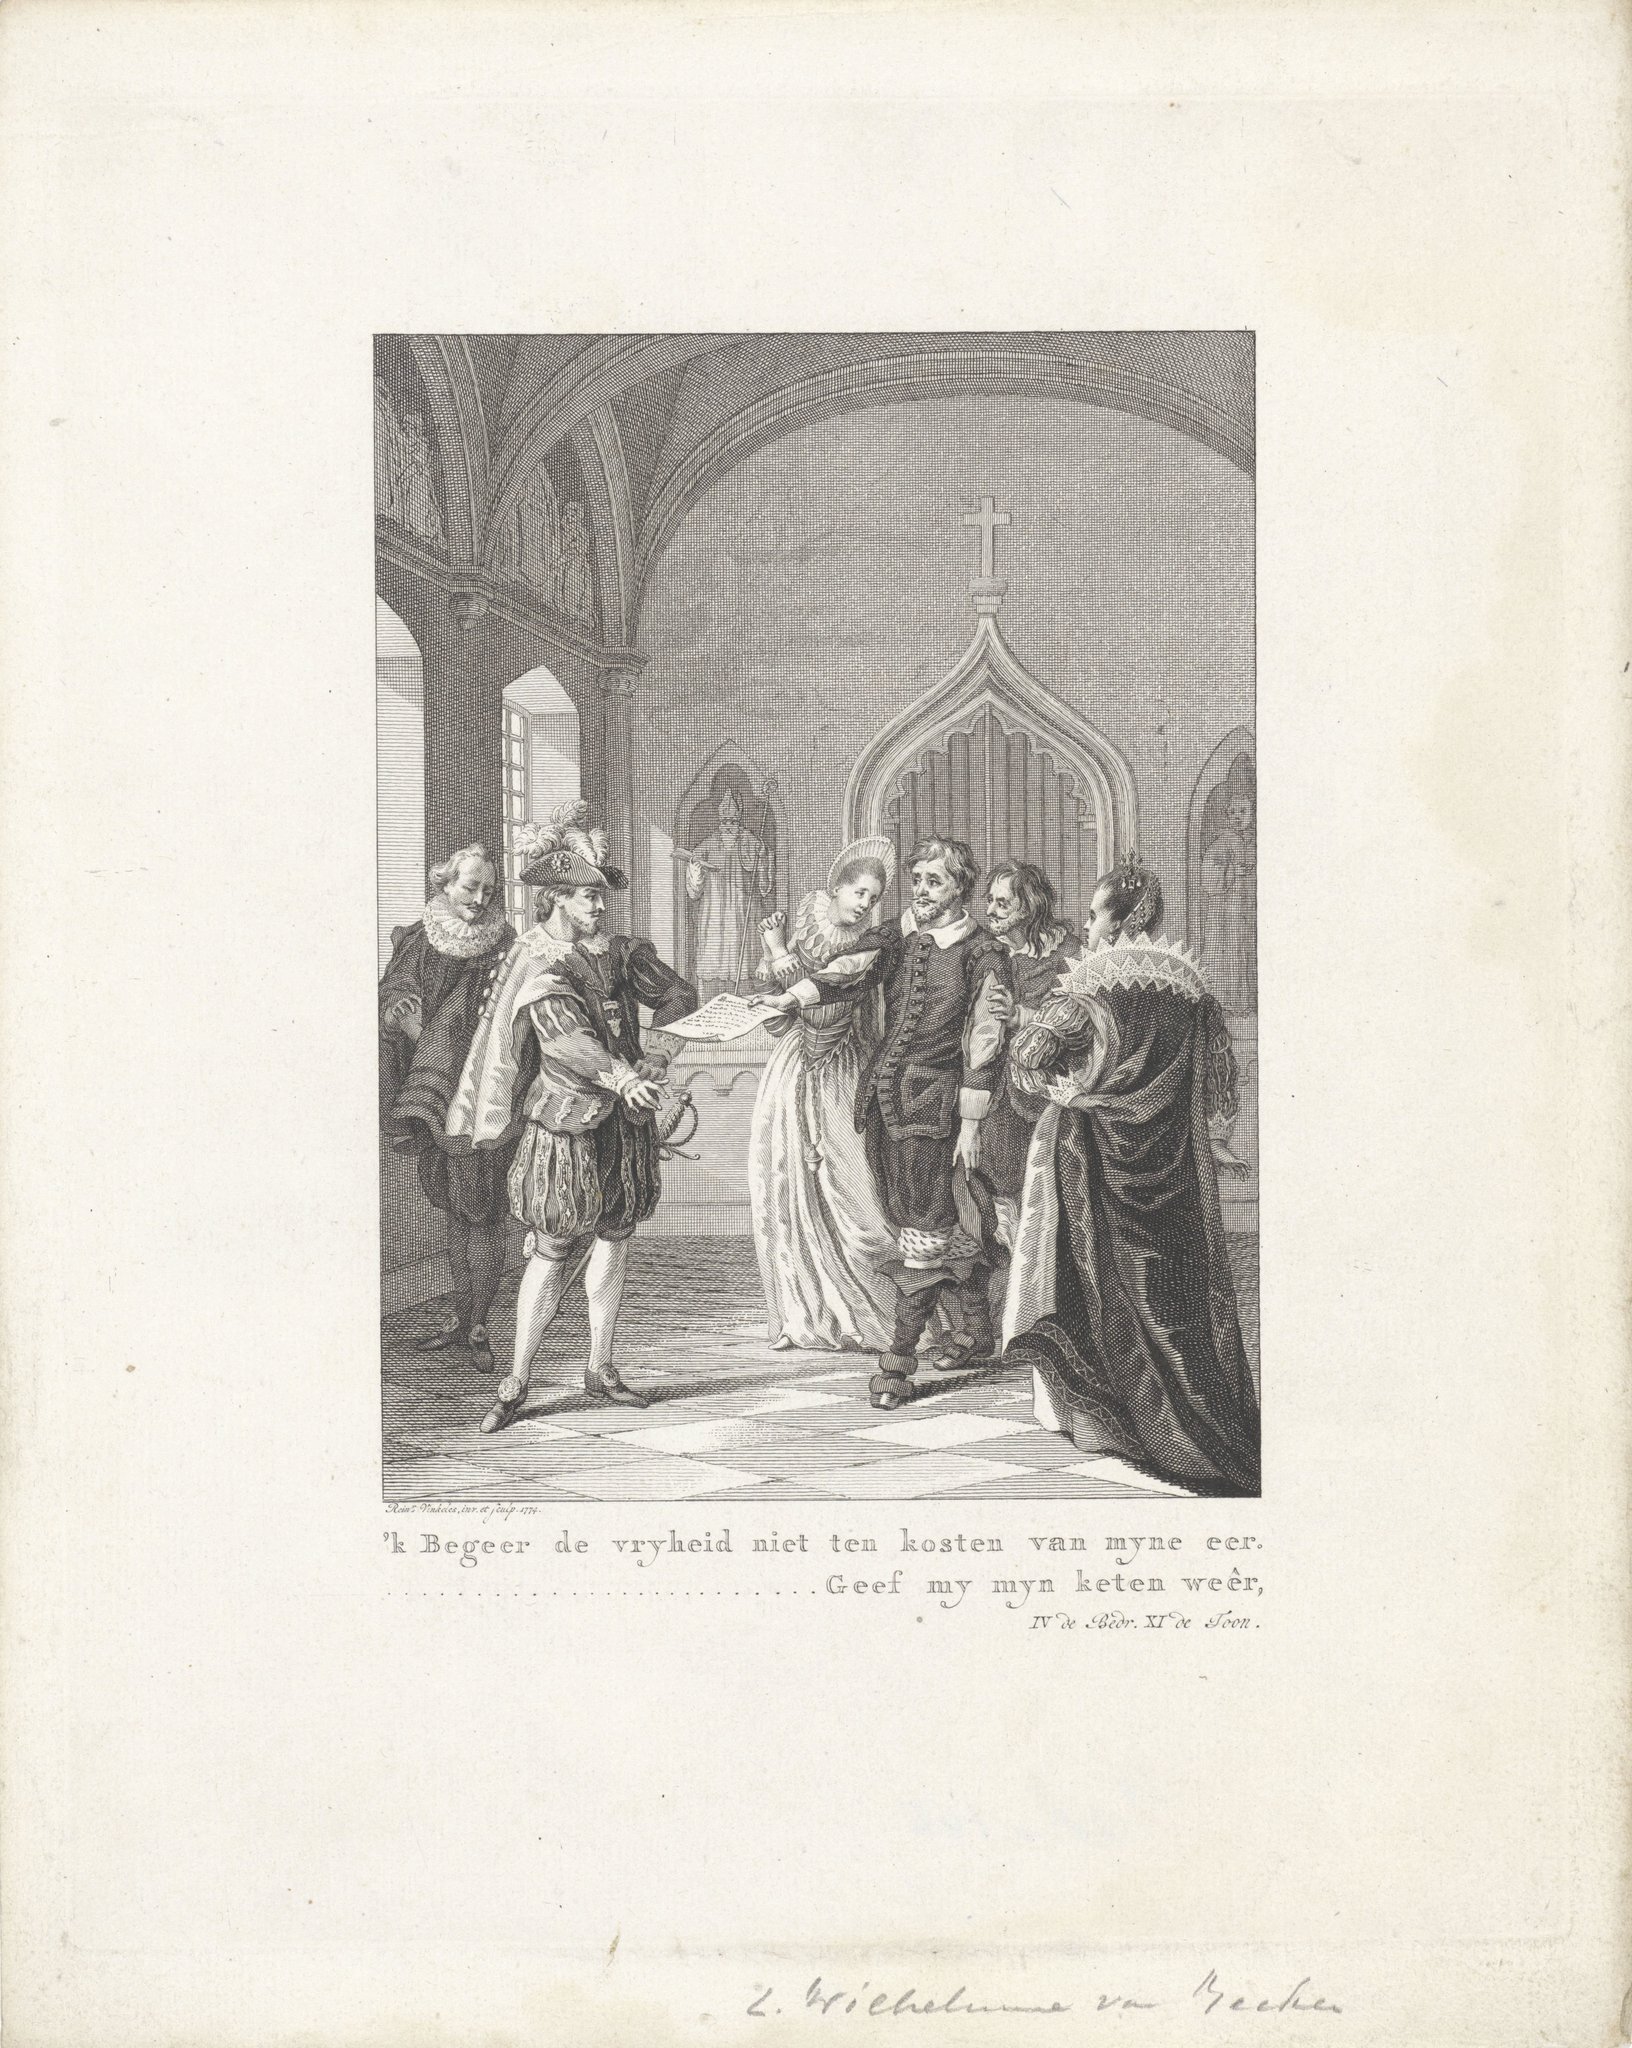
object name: print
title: Jacob Simonsz de Rijk geeft zijn ontslagbrief terug aan Cristóbal de Mondragón y Otalora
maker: reinier vinkeles (i)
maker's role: draughtsman, print maker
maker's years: 1741-1816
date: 1774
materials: paper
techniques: engraving, etching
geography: amsterdam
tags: antwerp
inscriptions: collector's mark: Lugt 2228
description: Illustratie voor 'Jacob Simonszoon de Rijk' in: Winter-van Merken, L. W. van en N. S. van Winter. Tooneelpoëzy, Deel 1. Amsterdam: Pieter Meijer, 1774.